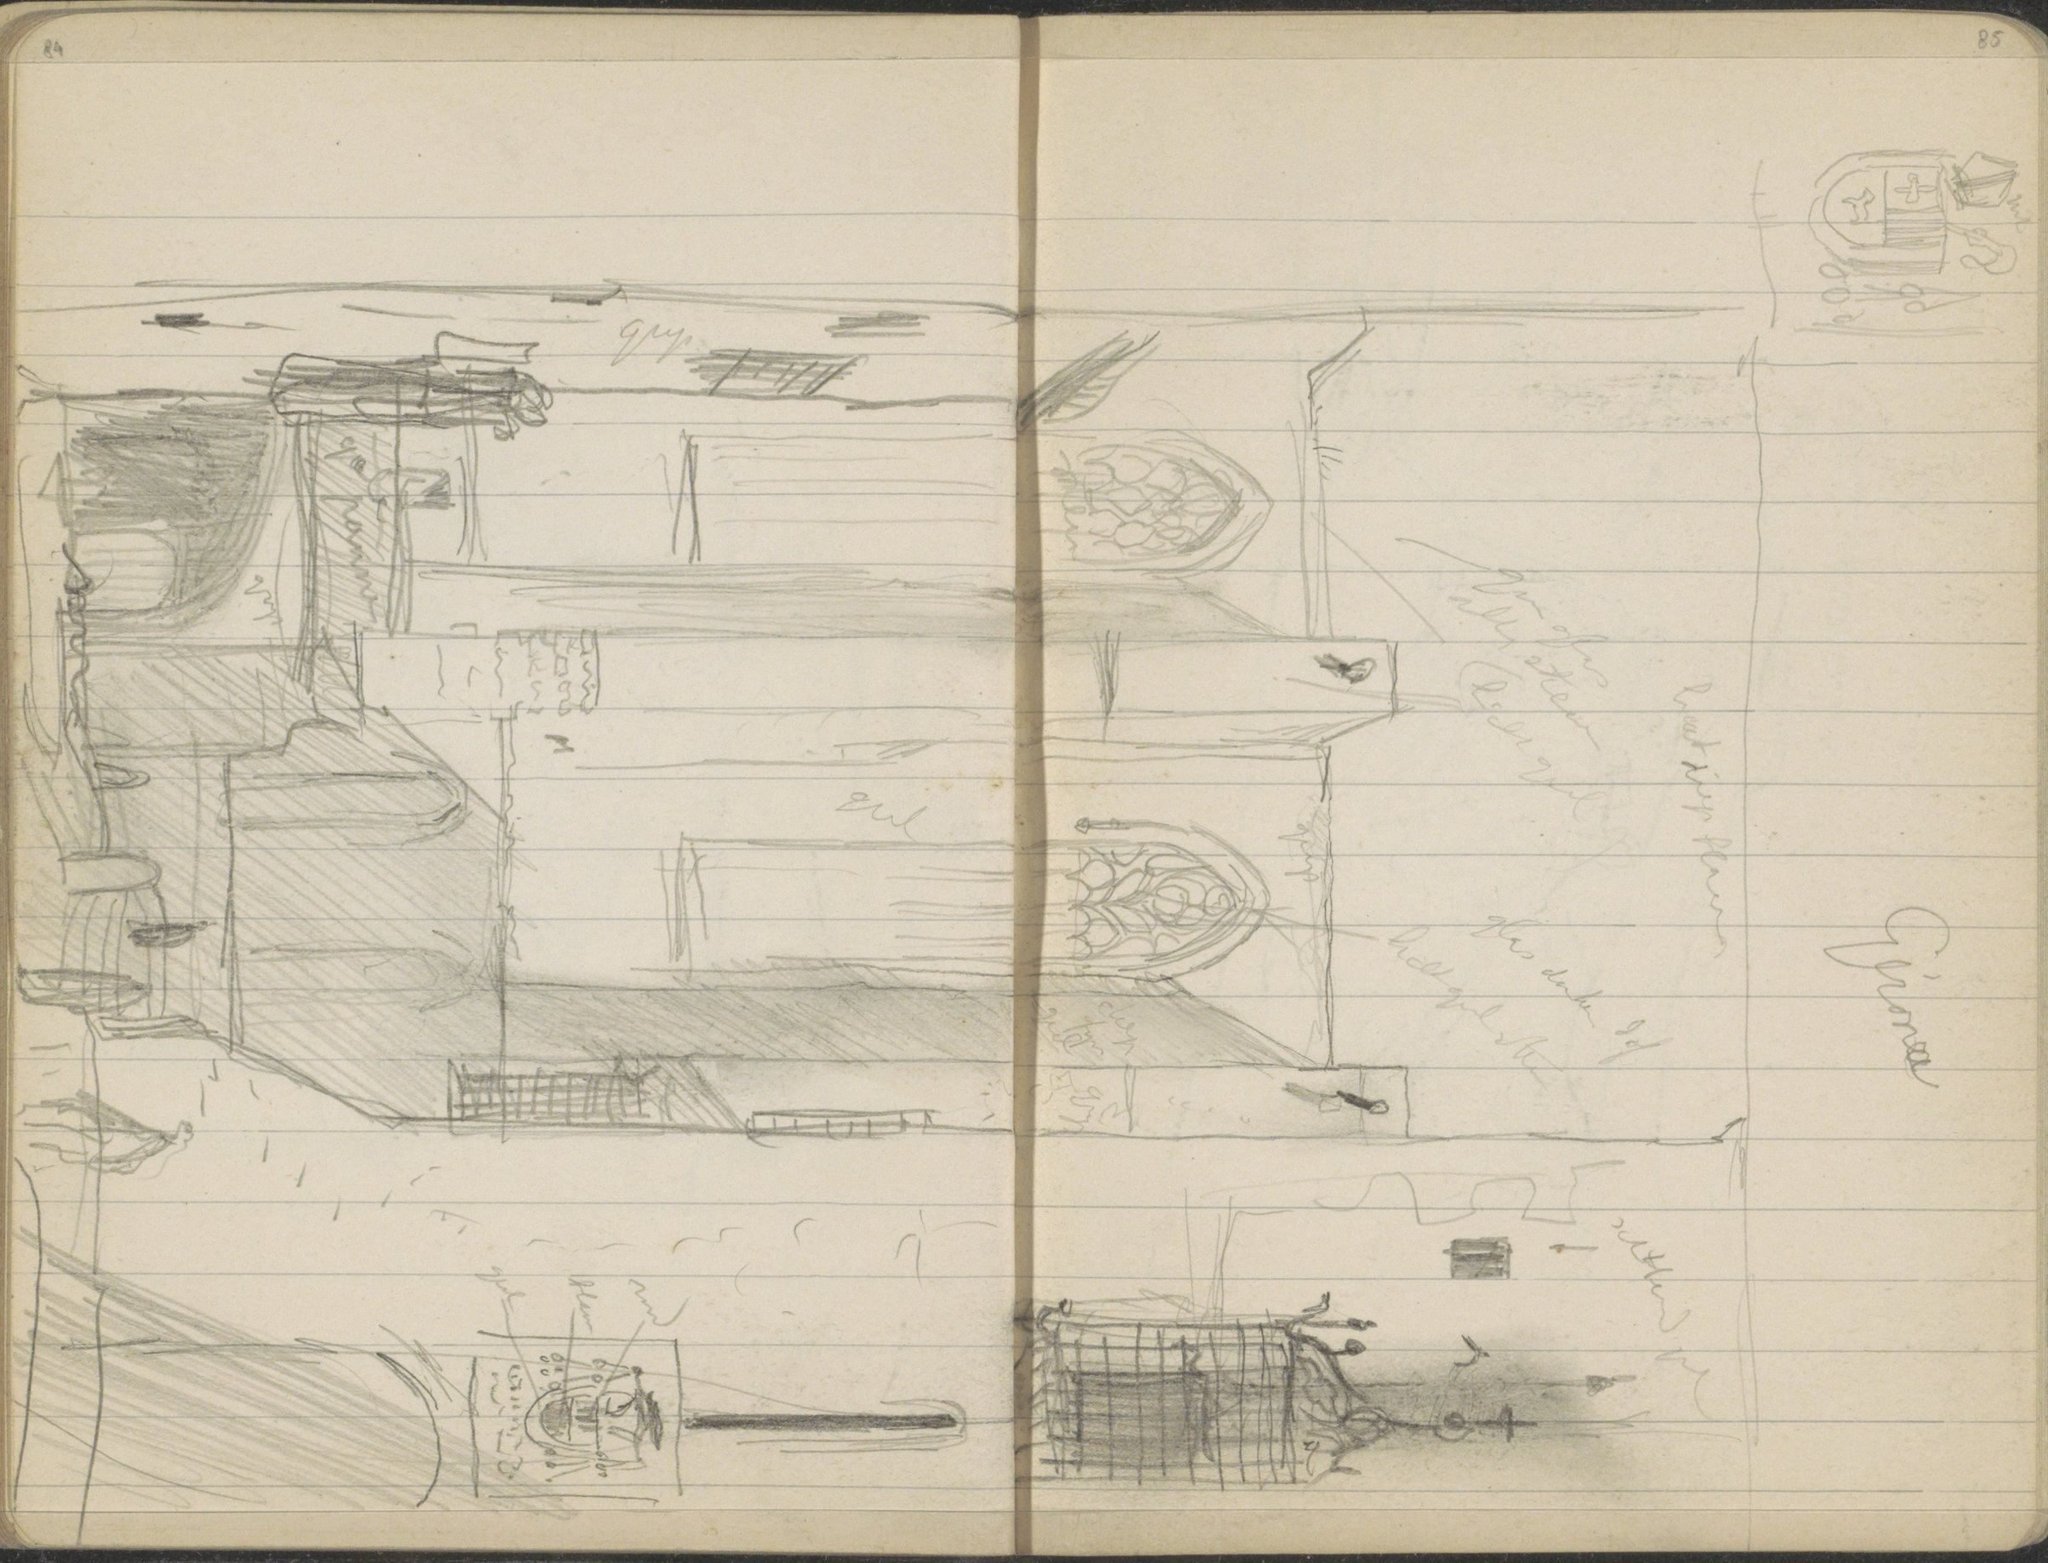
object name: sketchbook leaf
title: Zijaanzicht van de kathedraal van Girona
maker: marius bauer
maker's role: draughtsman, print maker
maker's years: 1867-1932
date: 1902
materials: pencil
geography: gerona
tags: church (exterior)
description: Op de voorgrond figuren bij een trap. Tevens een studie van een wapenschild. Pagina 84 en 85 uit een schetsboek met 50 bladen.